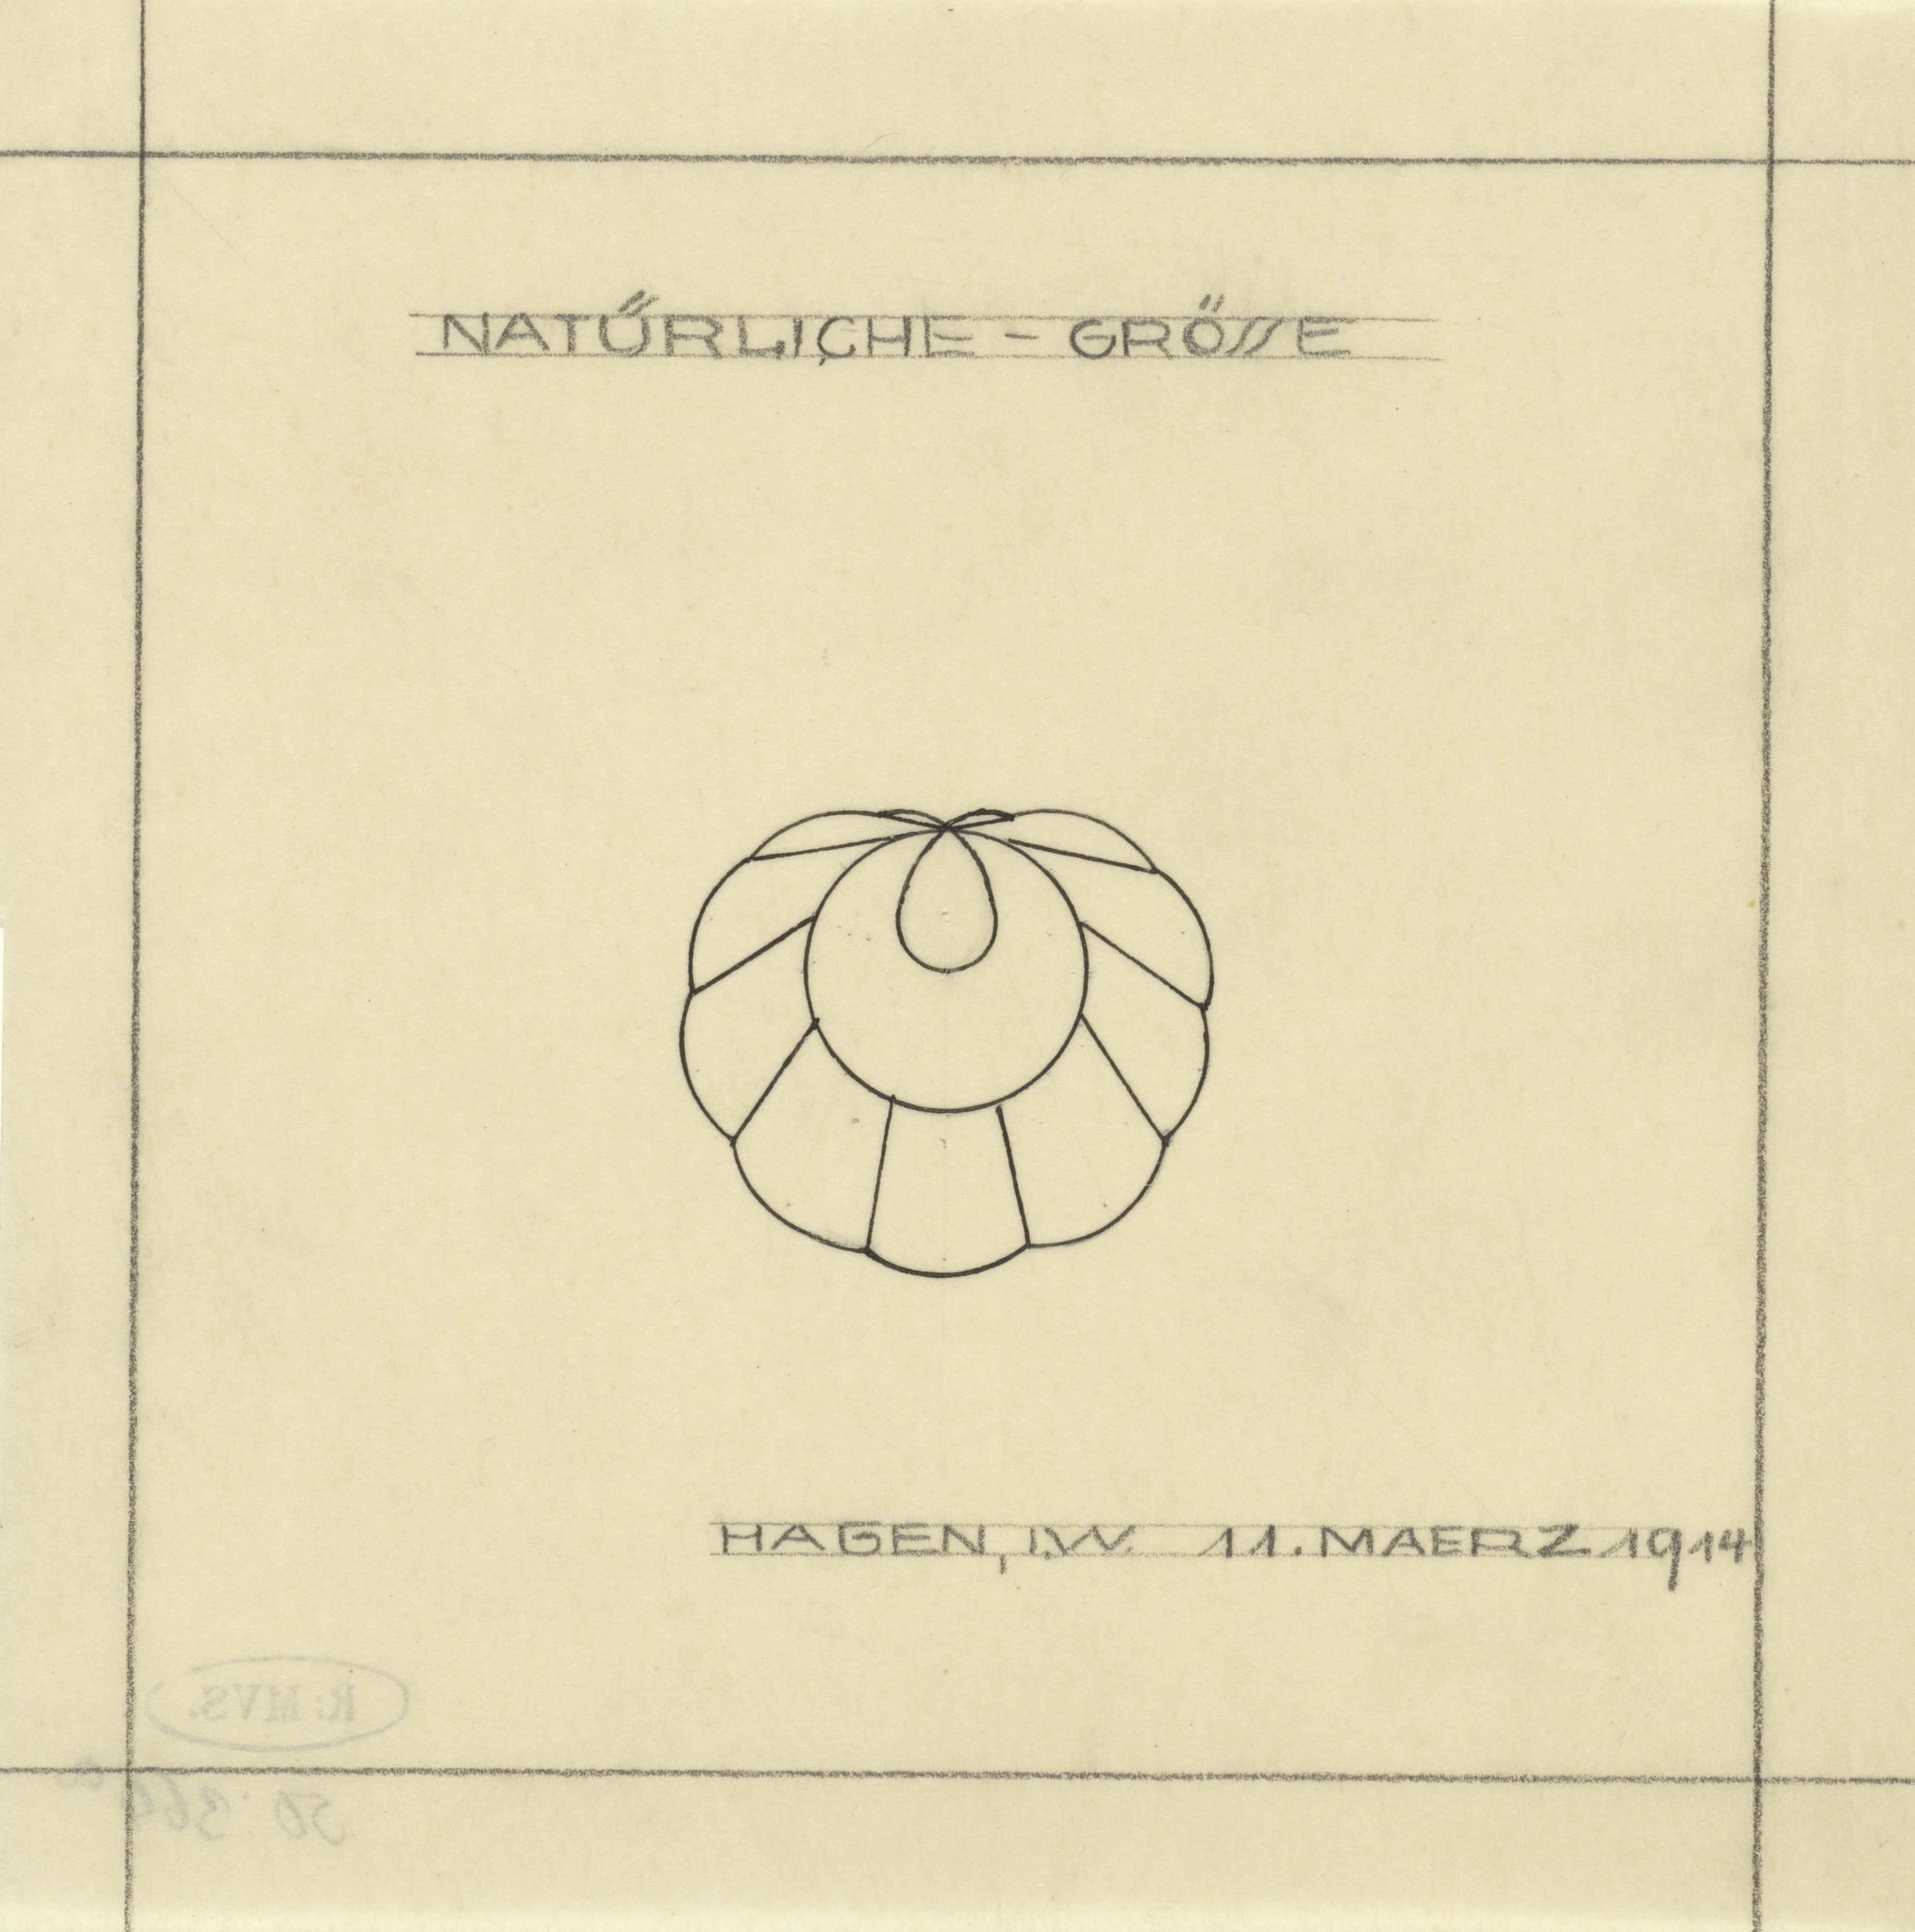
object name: drawing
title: Ontwerp voor een broche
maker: mathieu lauweriks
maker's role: designer, draughtsman, print maker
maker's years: 1864-1932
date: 1914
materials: ink, pencil, paper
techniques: pen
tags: brooch, agraffe, clasp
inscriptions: date: ‘11 Maerz 1914’